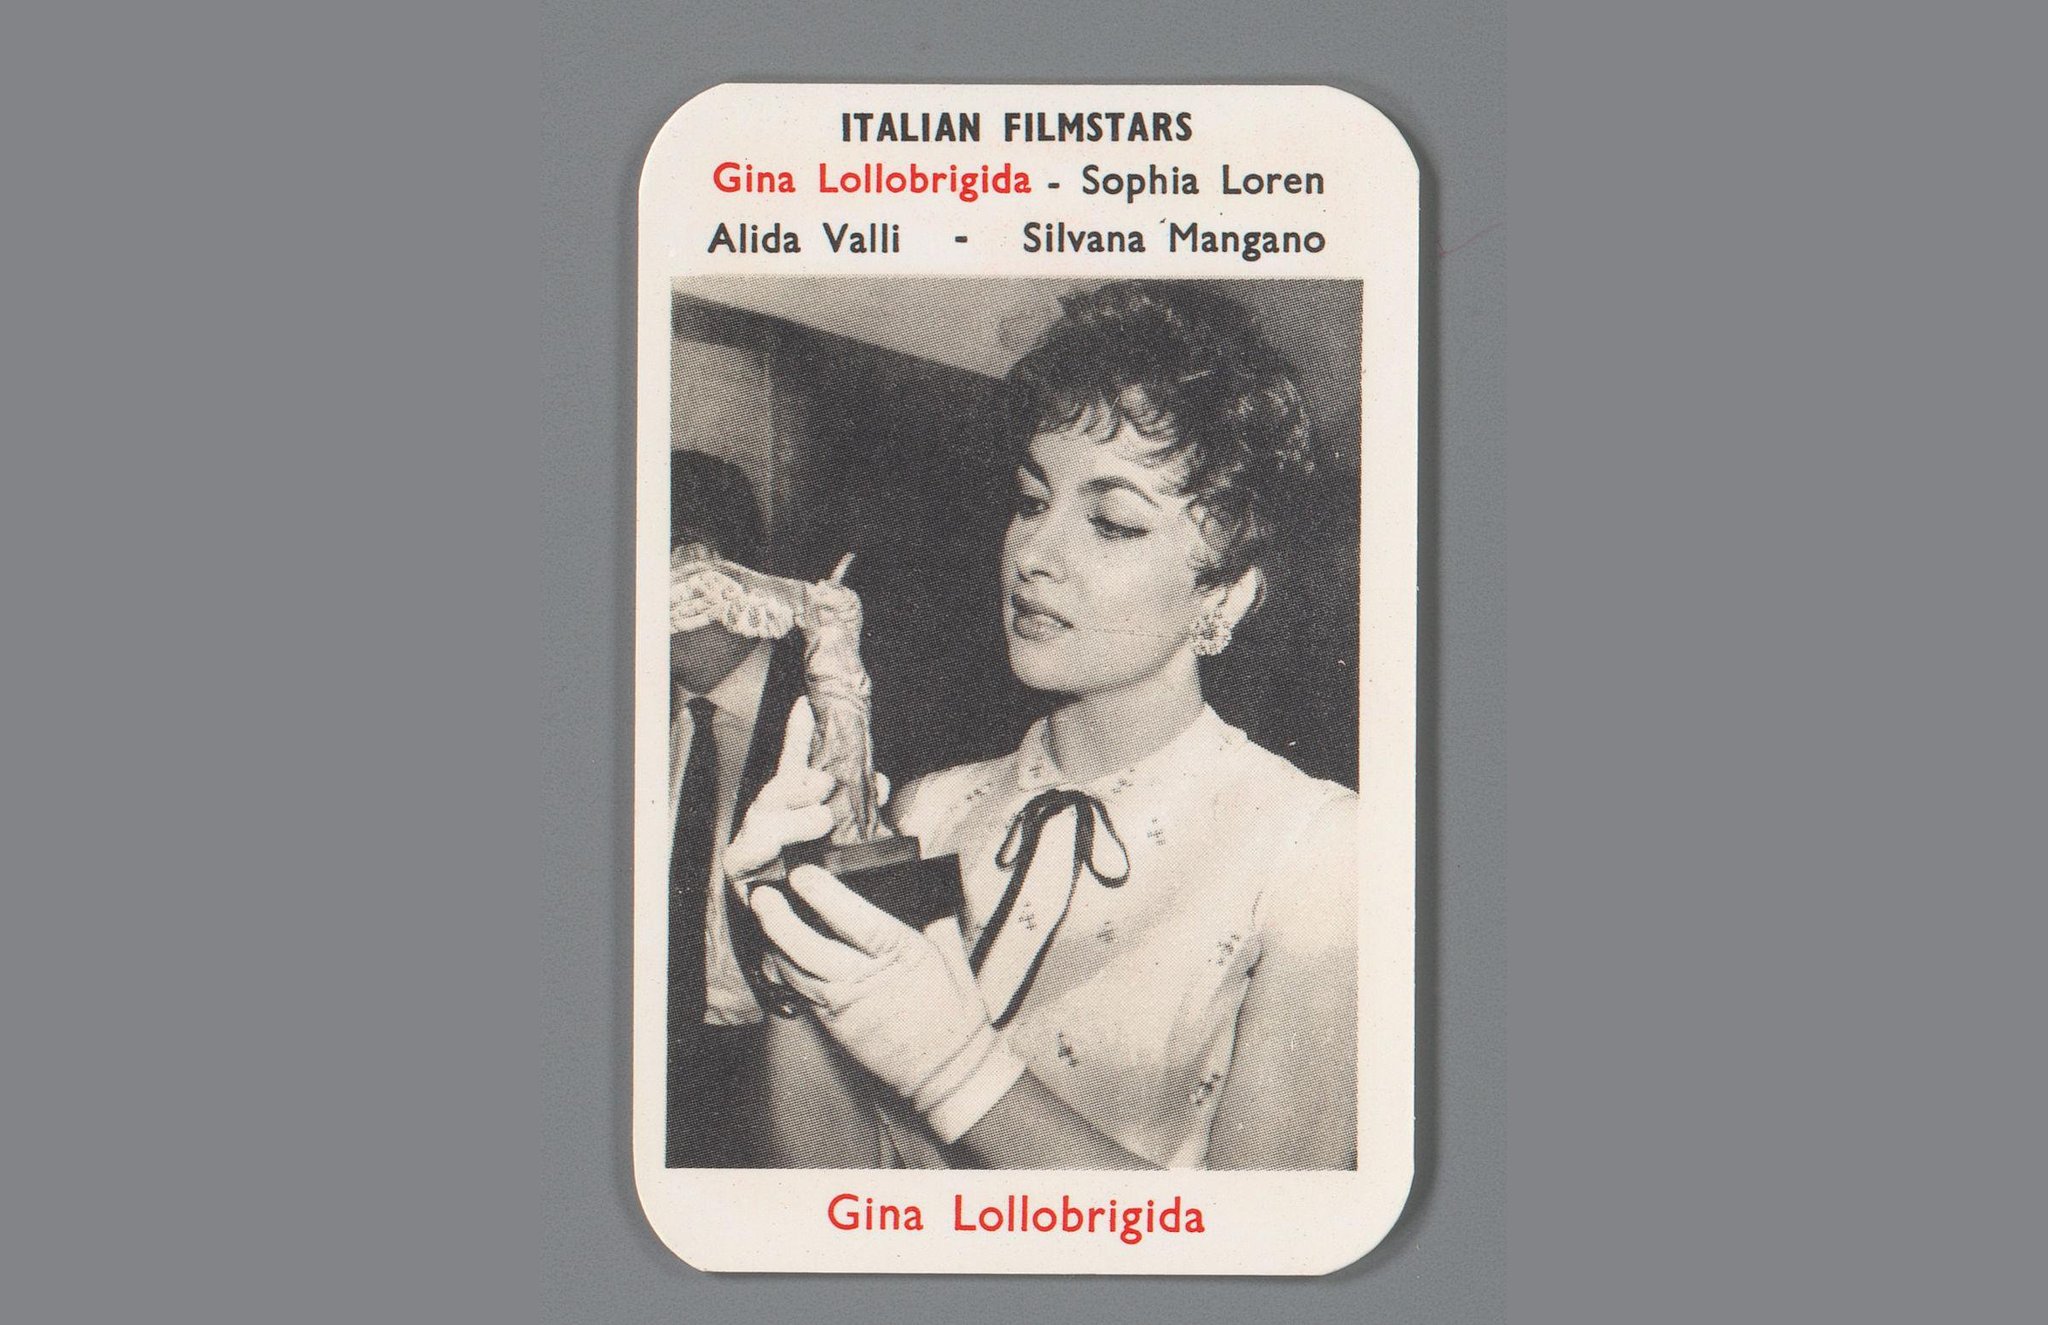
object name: photomechanical print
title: Italian Filmstars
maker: Anonymous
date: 1960-1970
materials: paper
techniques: autotype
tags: portrait of actor, actress